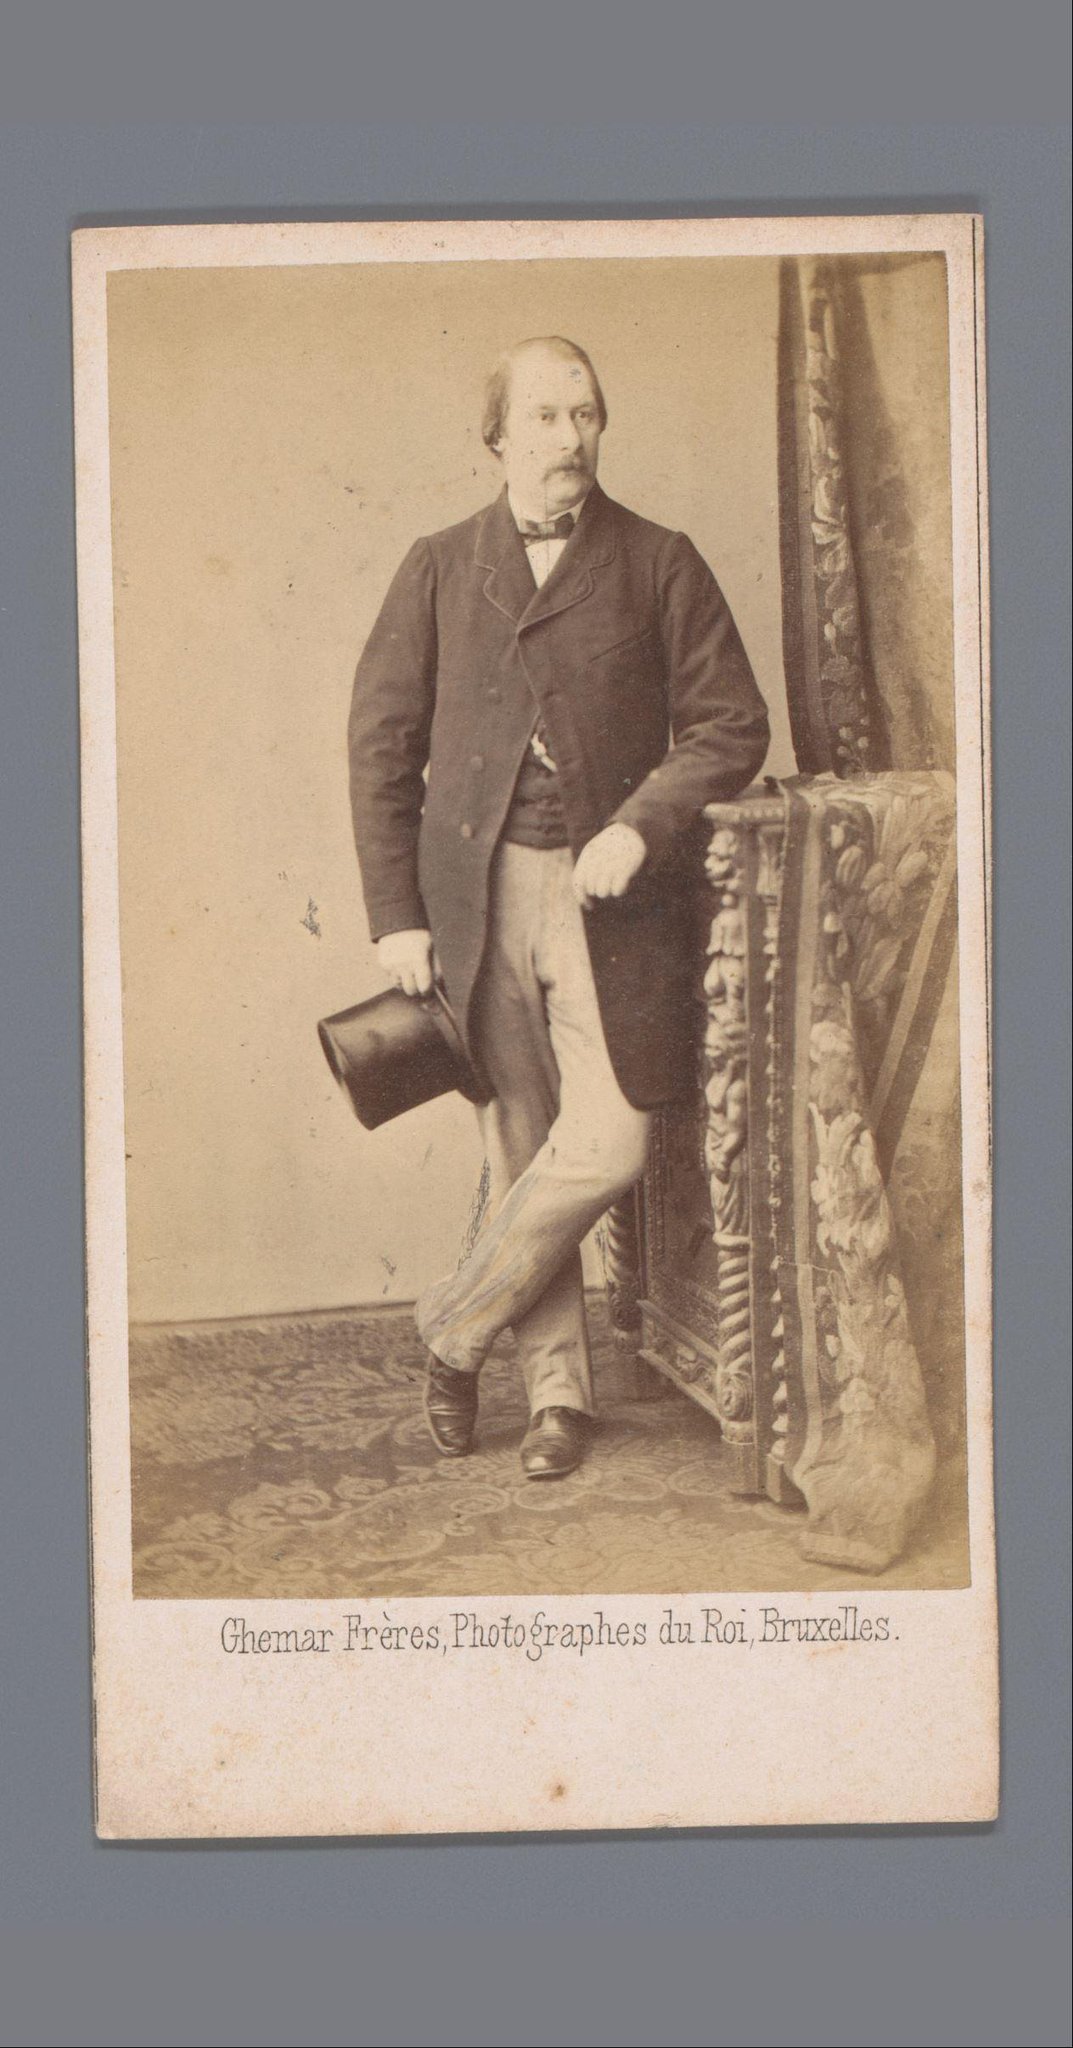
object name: photograph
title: Portret van een onbekende man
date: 1859-1894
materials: cardboard, paper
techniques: albumen print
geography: brussels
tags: adult man, anonymous historical person portrayed, head-gear: top hat, brussels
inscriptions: inscription: ‘Atelier de photographie./ Ghémar Frères,/ Photographes du roi,/ 27, Rue de l'Ecuyer,/ entrée par la porte cochère,/ Bruxelles.’, inscription: ‘Ghemar Frères, Photographes du Roi, Bruxelles.’